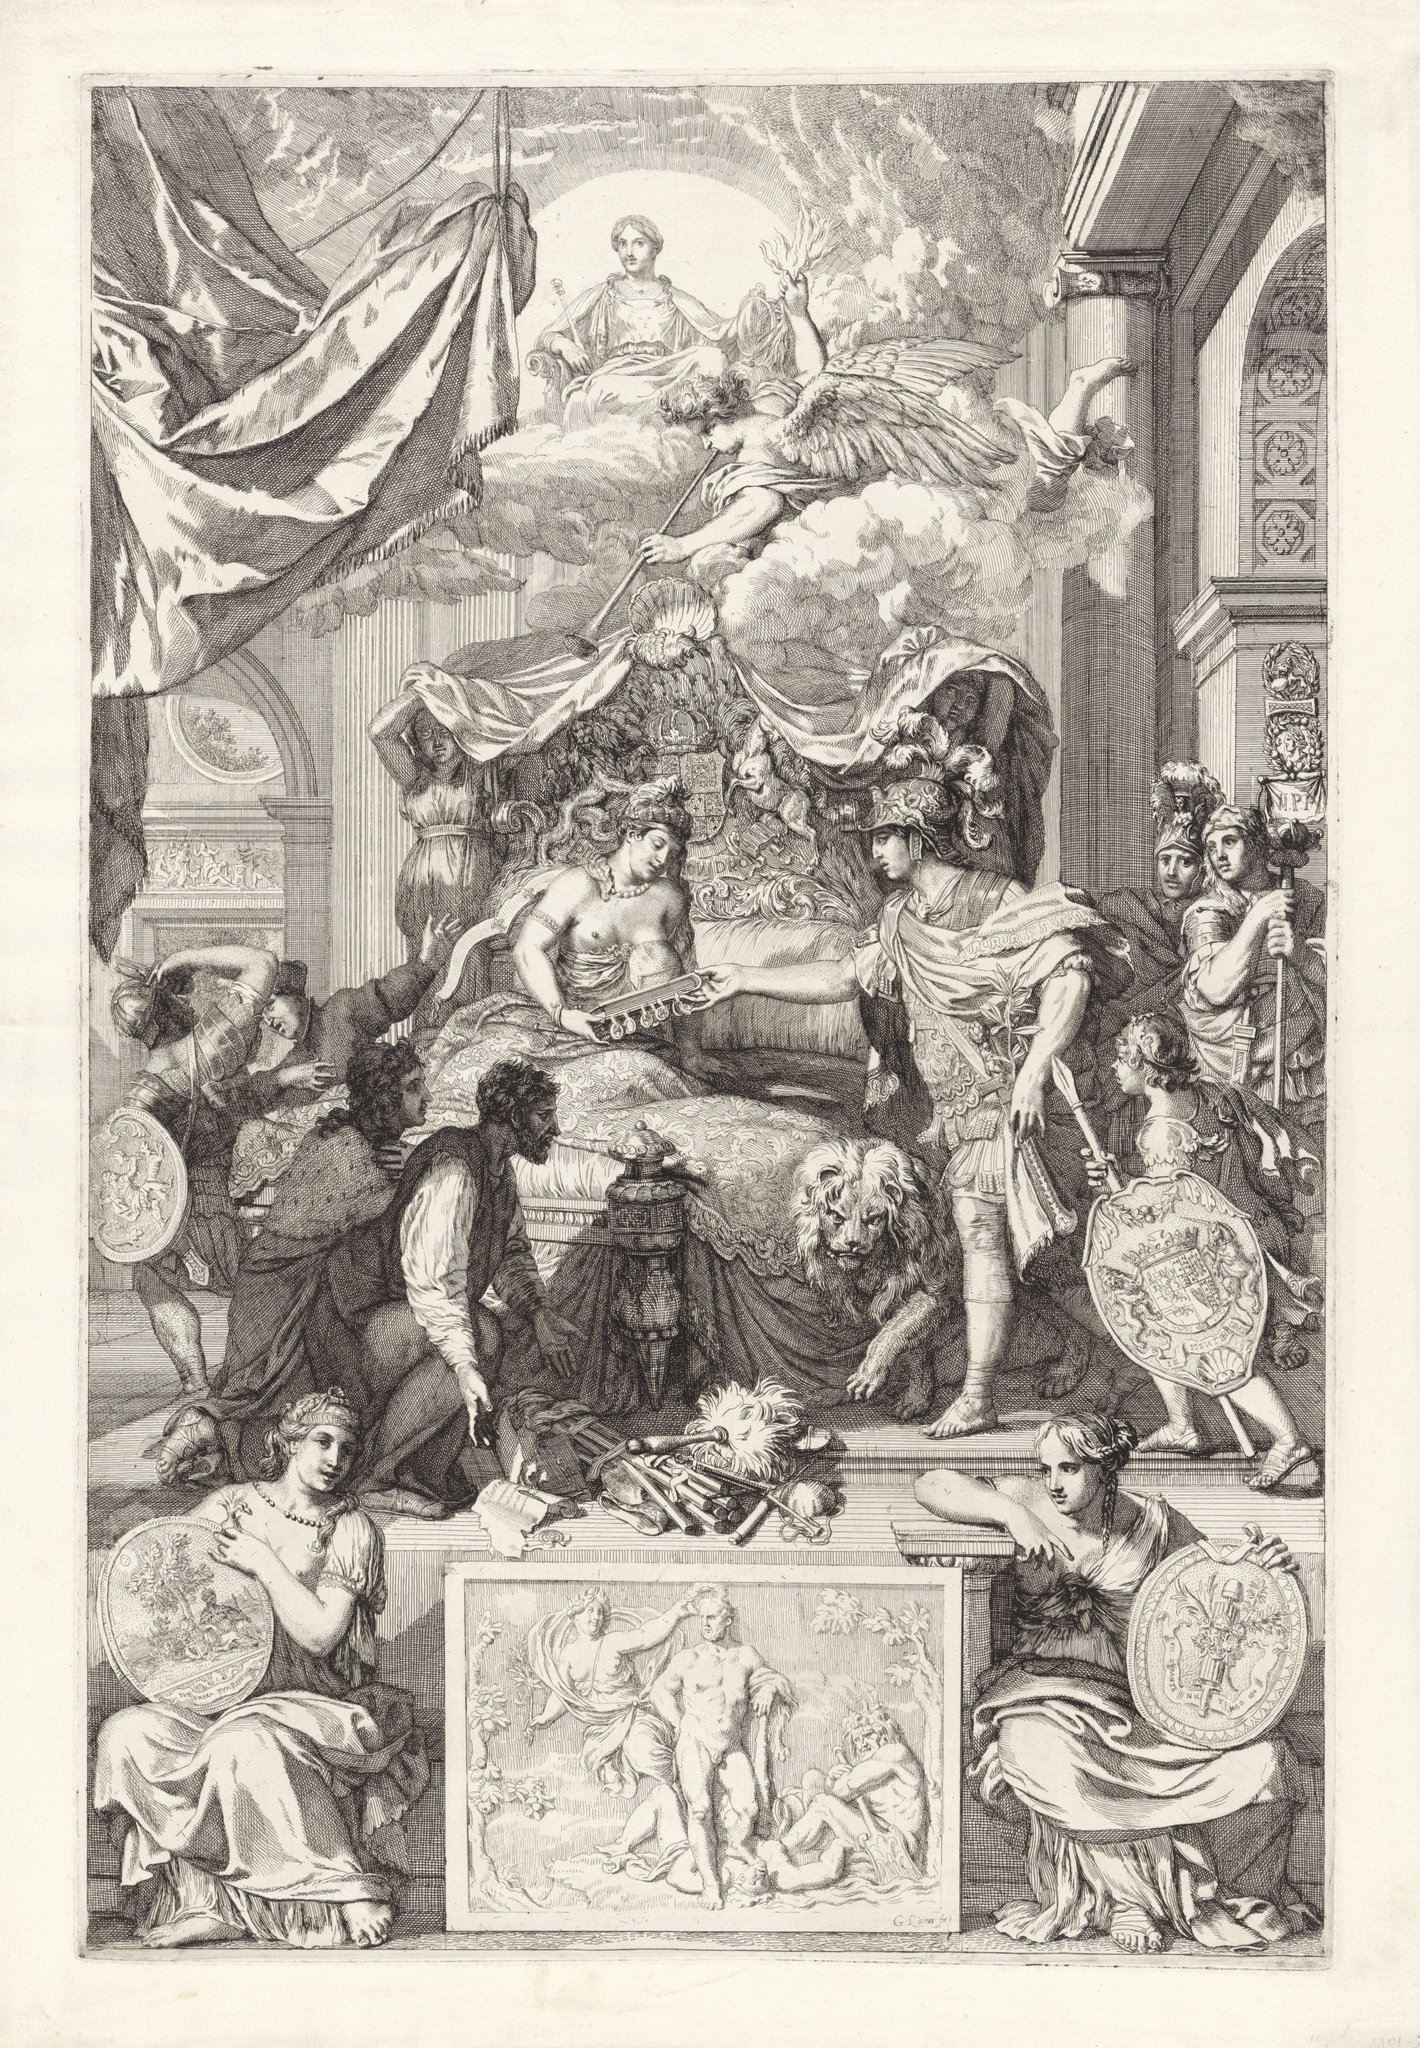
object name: print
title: Allegorie op het herstel van de ware godsdienst in Engeland met de komst van de prins van Oranje, 1688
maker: gerard de lairesse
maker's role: draughtsman, painter, print maker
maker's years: 1641-1711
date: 1688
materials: paper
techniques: etching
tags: (story of) hercules (heracles), personifications of countries, nations, states, districts, etc., lion's den (+ animals used symbolically), truth; 'verità' (ripa), netherlands, england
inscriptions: collector's mark: Lugt 240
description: Allegorie op het herstel van de ware godsdienst in Engeland met de komst van de prins van Oranje, 1688. Een Romeins veldheer, Willem III, overhandigt een verzegelde bijbel aan de in bed gelegen Engelse Maagd. Willem III wordt vergezeld door de Hollandse Leeuw, aan het voeteneind knielen de Engelse lord en burger. In de lucht vliegt de engel van de wraak Gods met bliksemschichten en een bazuin, hierboven troont de Waarheid. Op de voorgrond zitten twee vrouwenfiguren aan weerszijden van een fries met de beeltenis van Hercules die wordt gekroond.